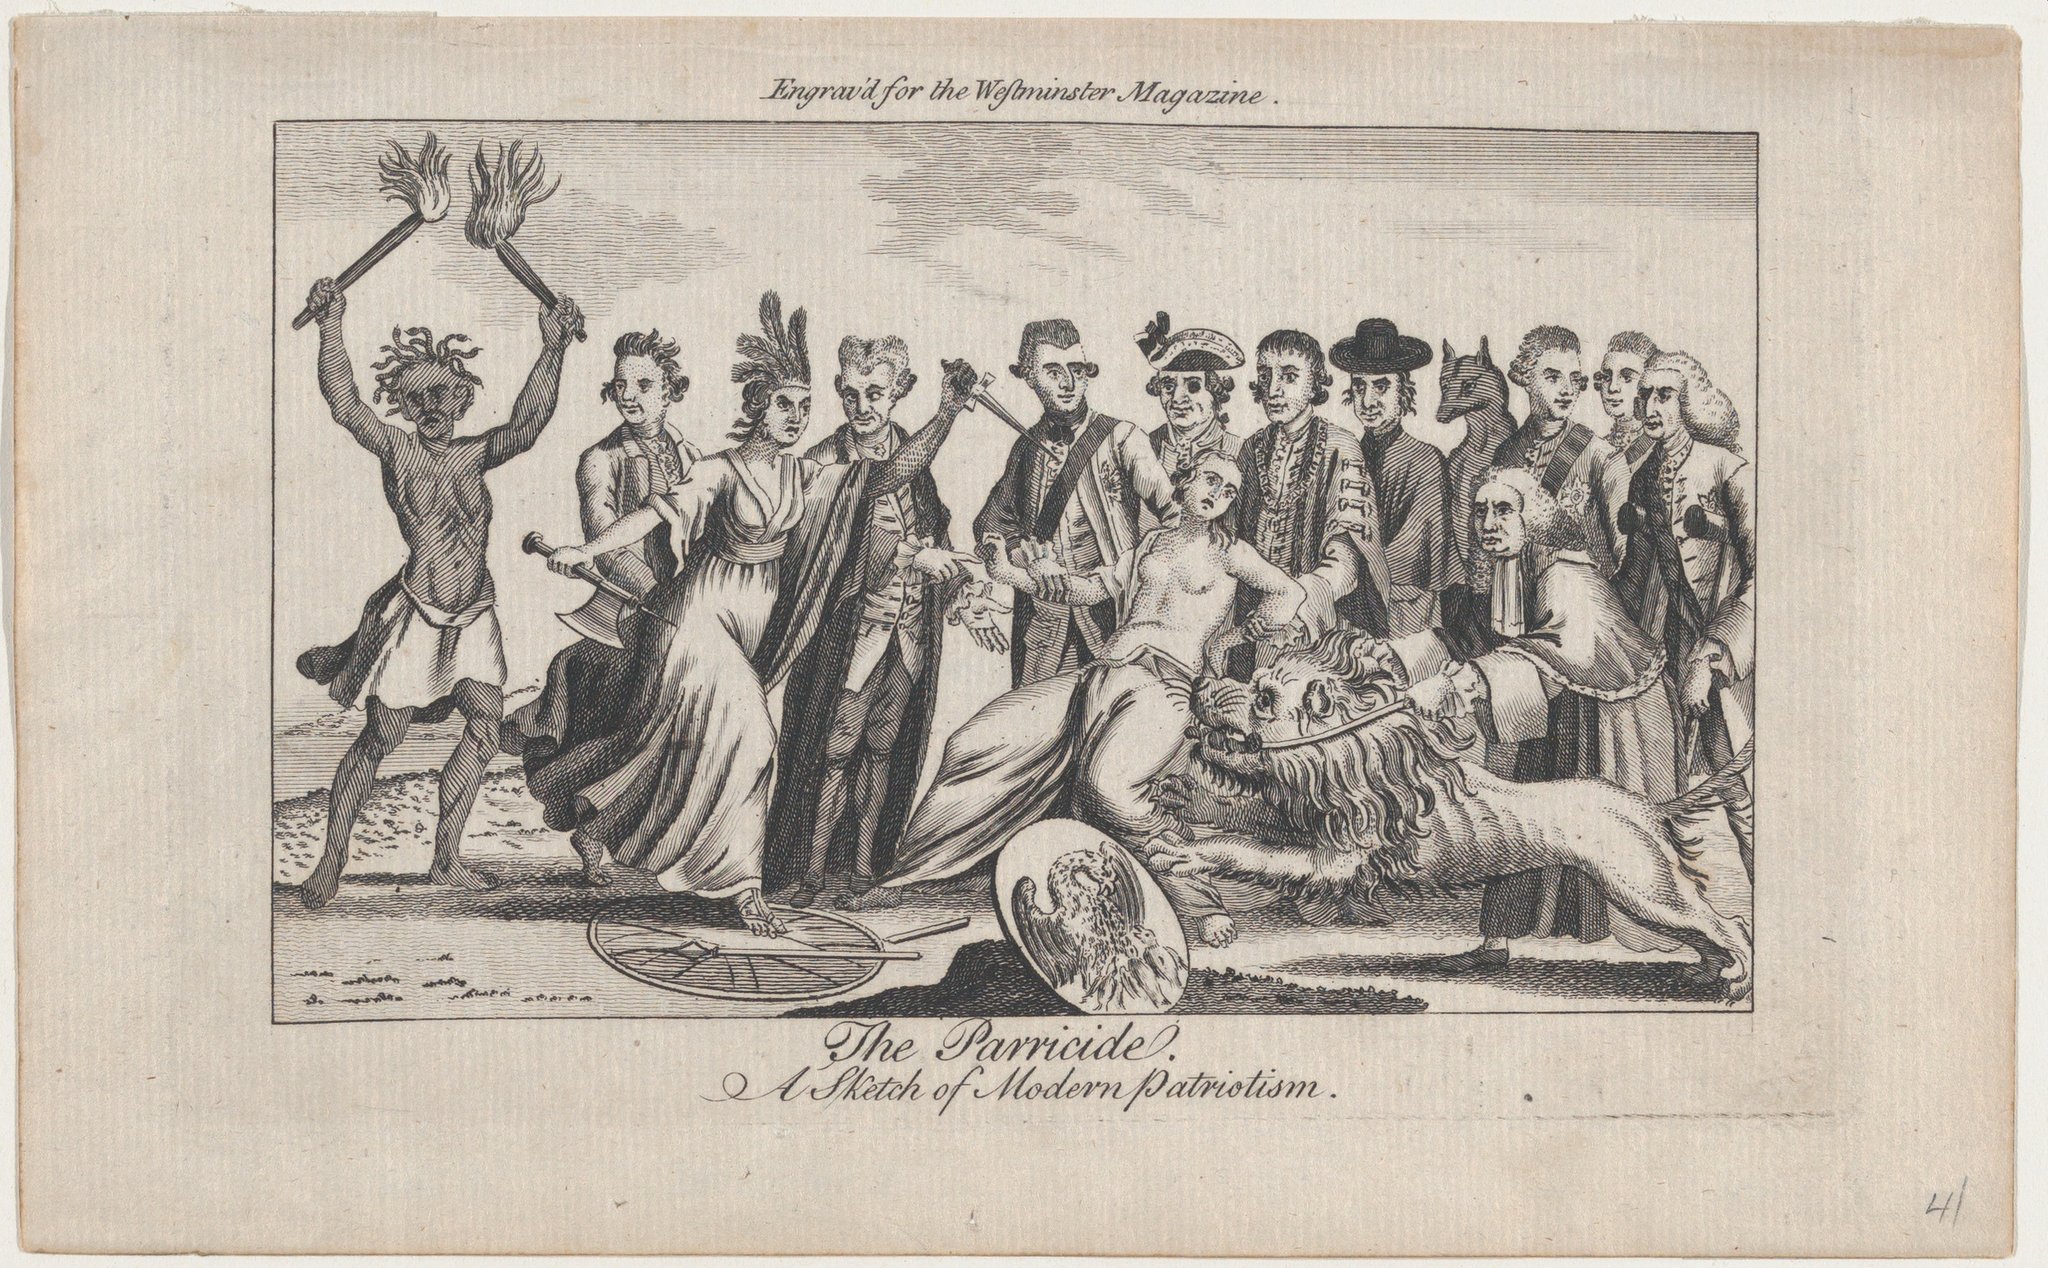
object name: print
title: The Parricide, a Sketch of Modern Patriotism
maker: anonymous, british, 18th century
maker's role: artist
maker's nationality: british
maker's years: 1700-1800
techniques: engraving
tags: satire,american revolution,men,women,lions,politics